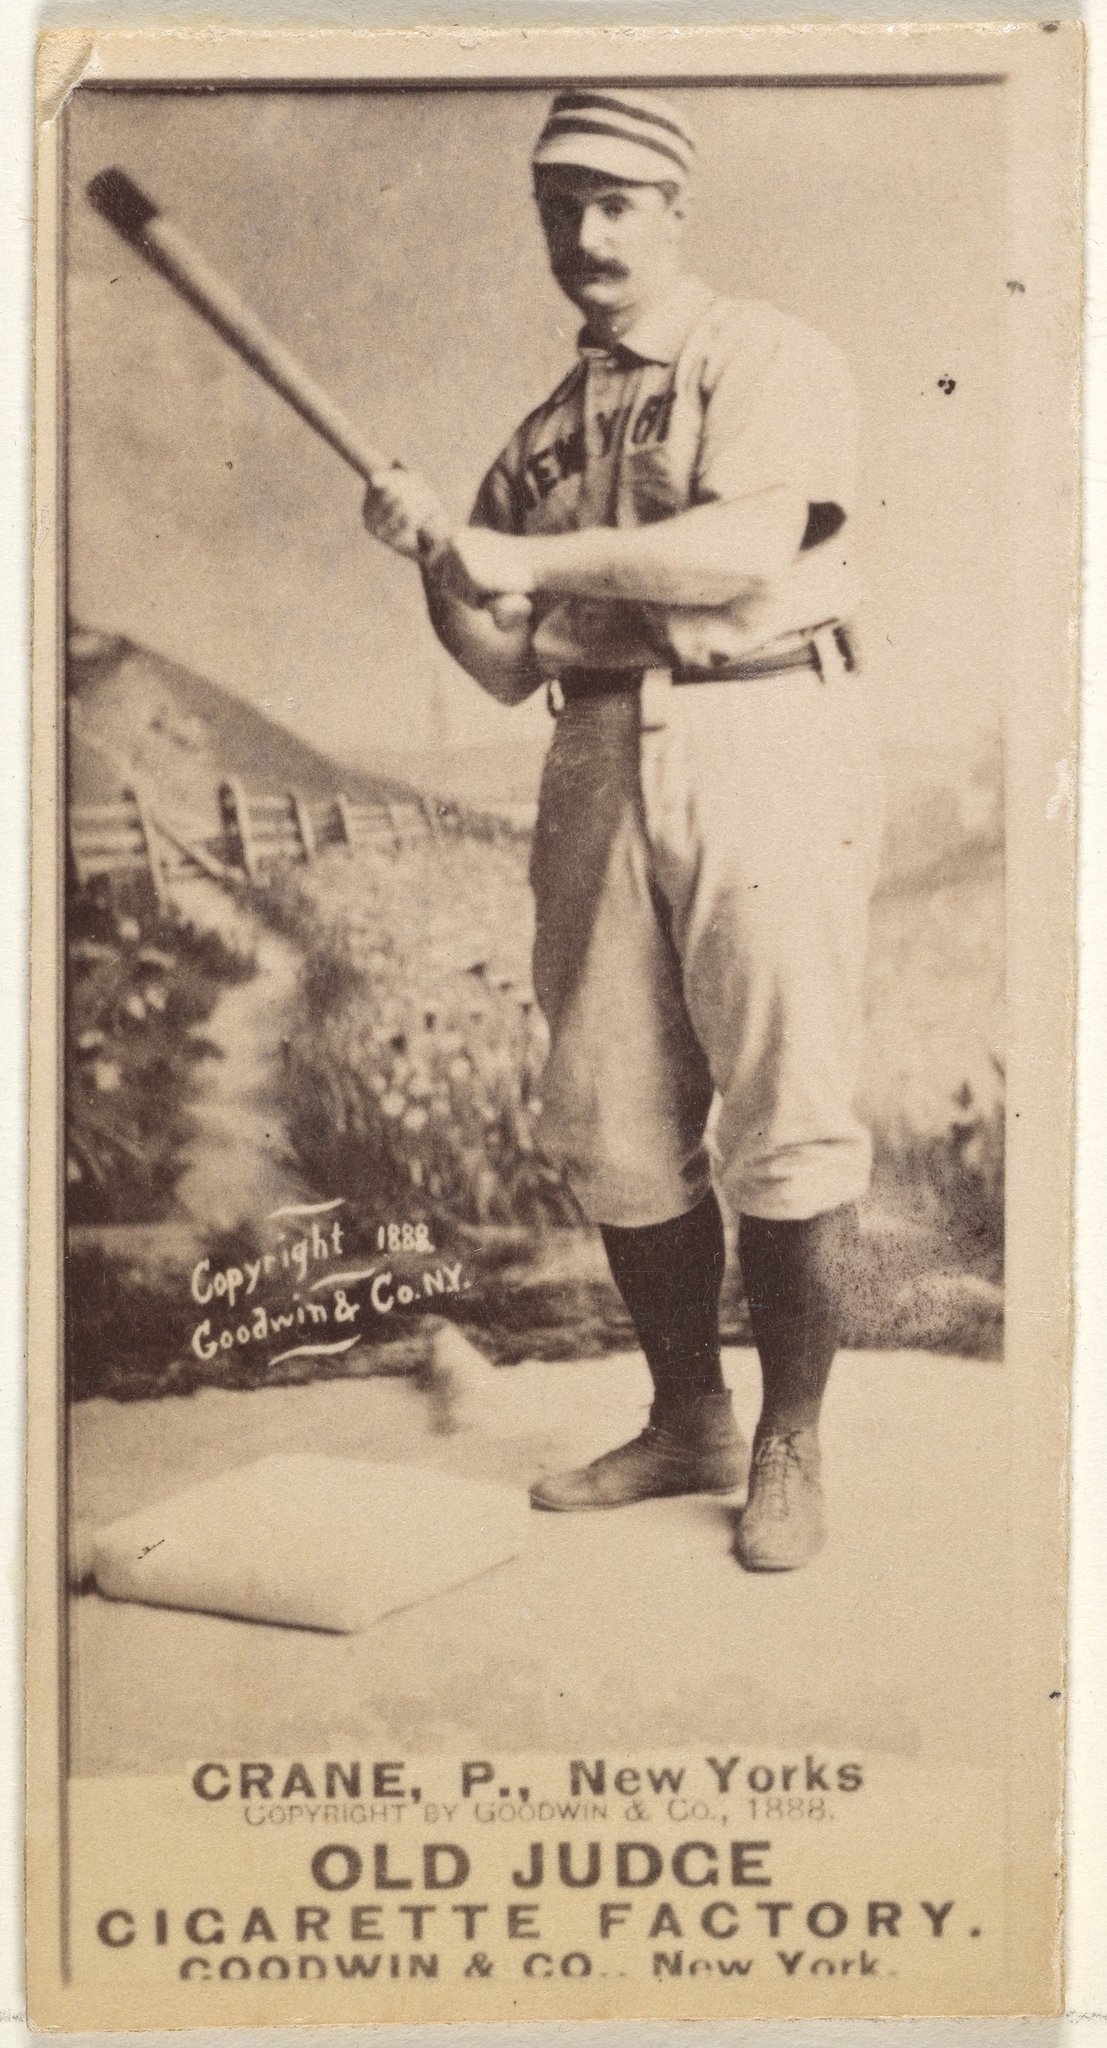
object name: baseball card, photograph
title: Ed Crane, Pitcher, New York, from the Old Judge series (N172) for Old Judge Cigarettes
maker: goodwin & company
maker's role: publisher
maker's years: 1850-1950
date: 1888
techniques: albumen silver print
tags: men,portraits,baseball,athletes